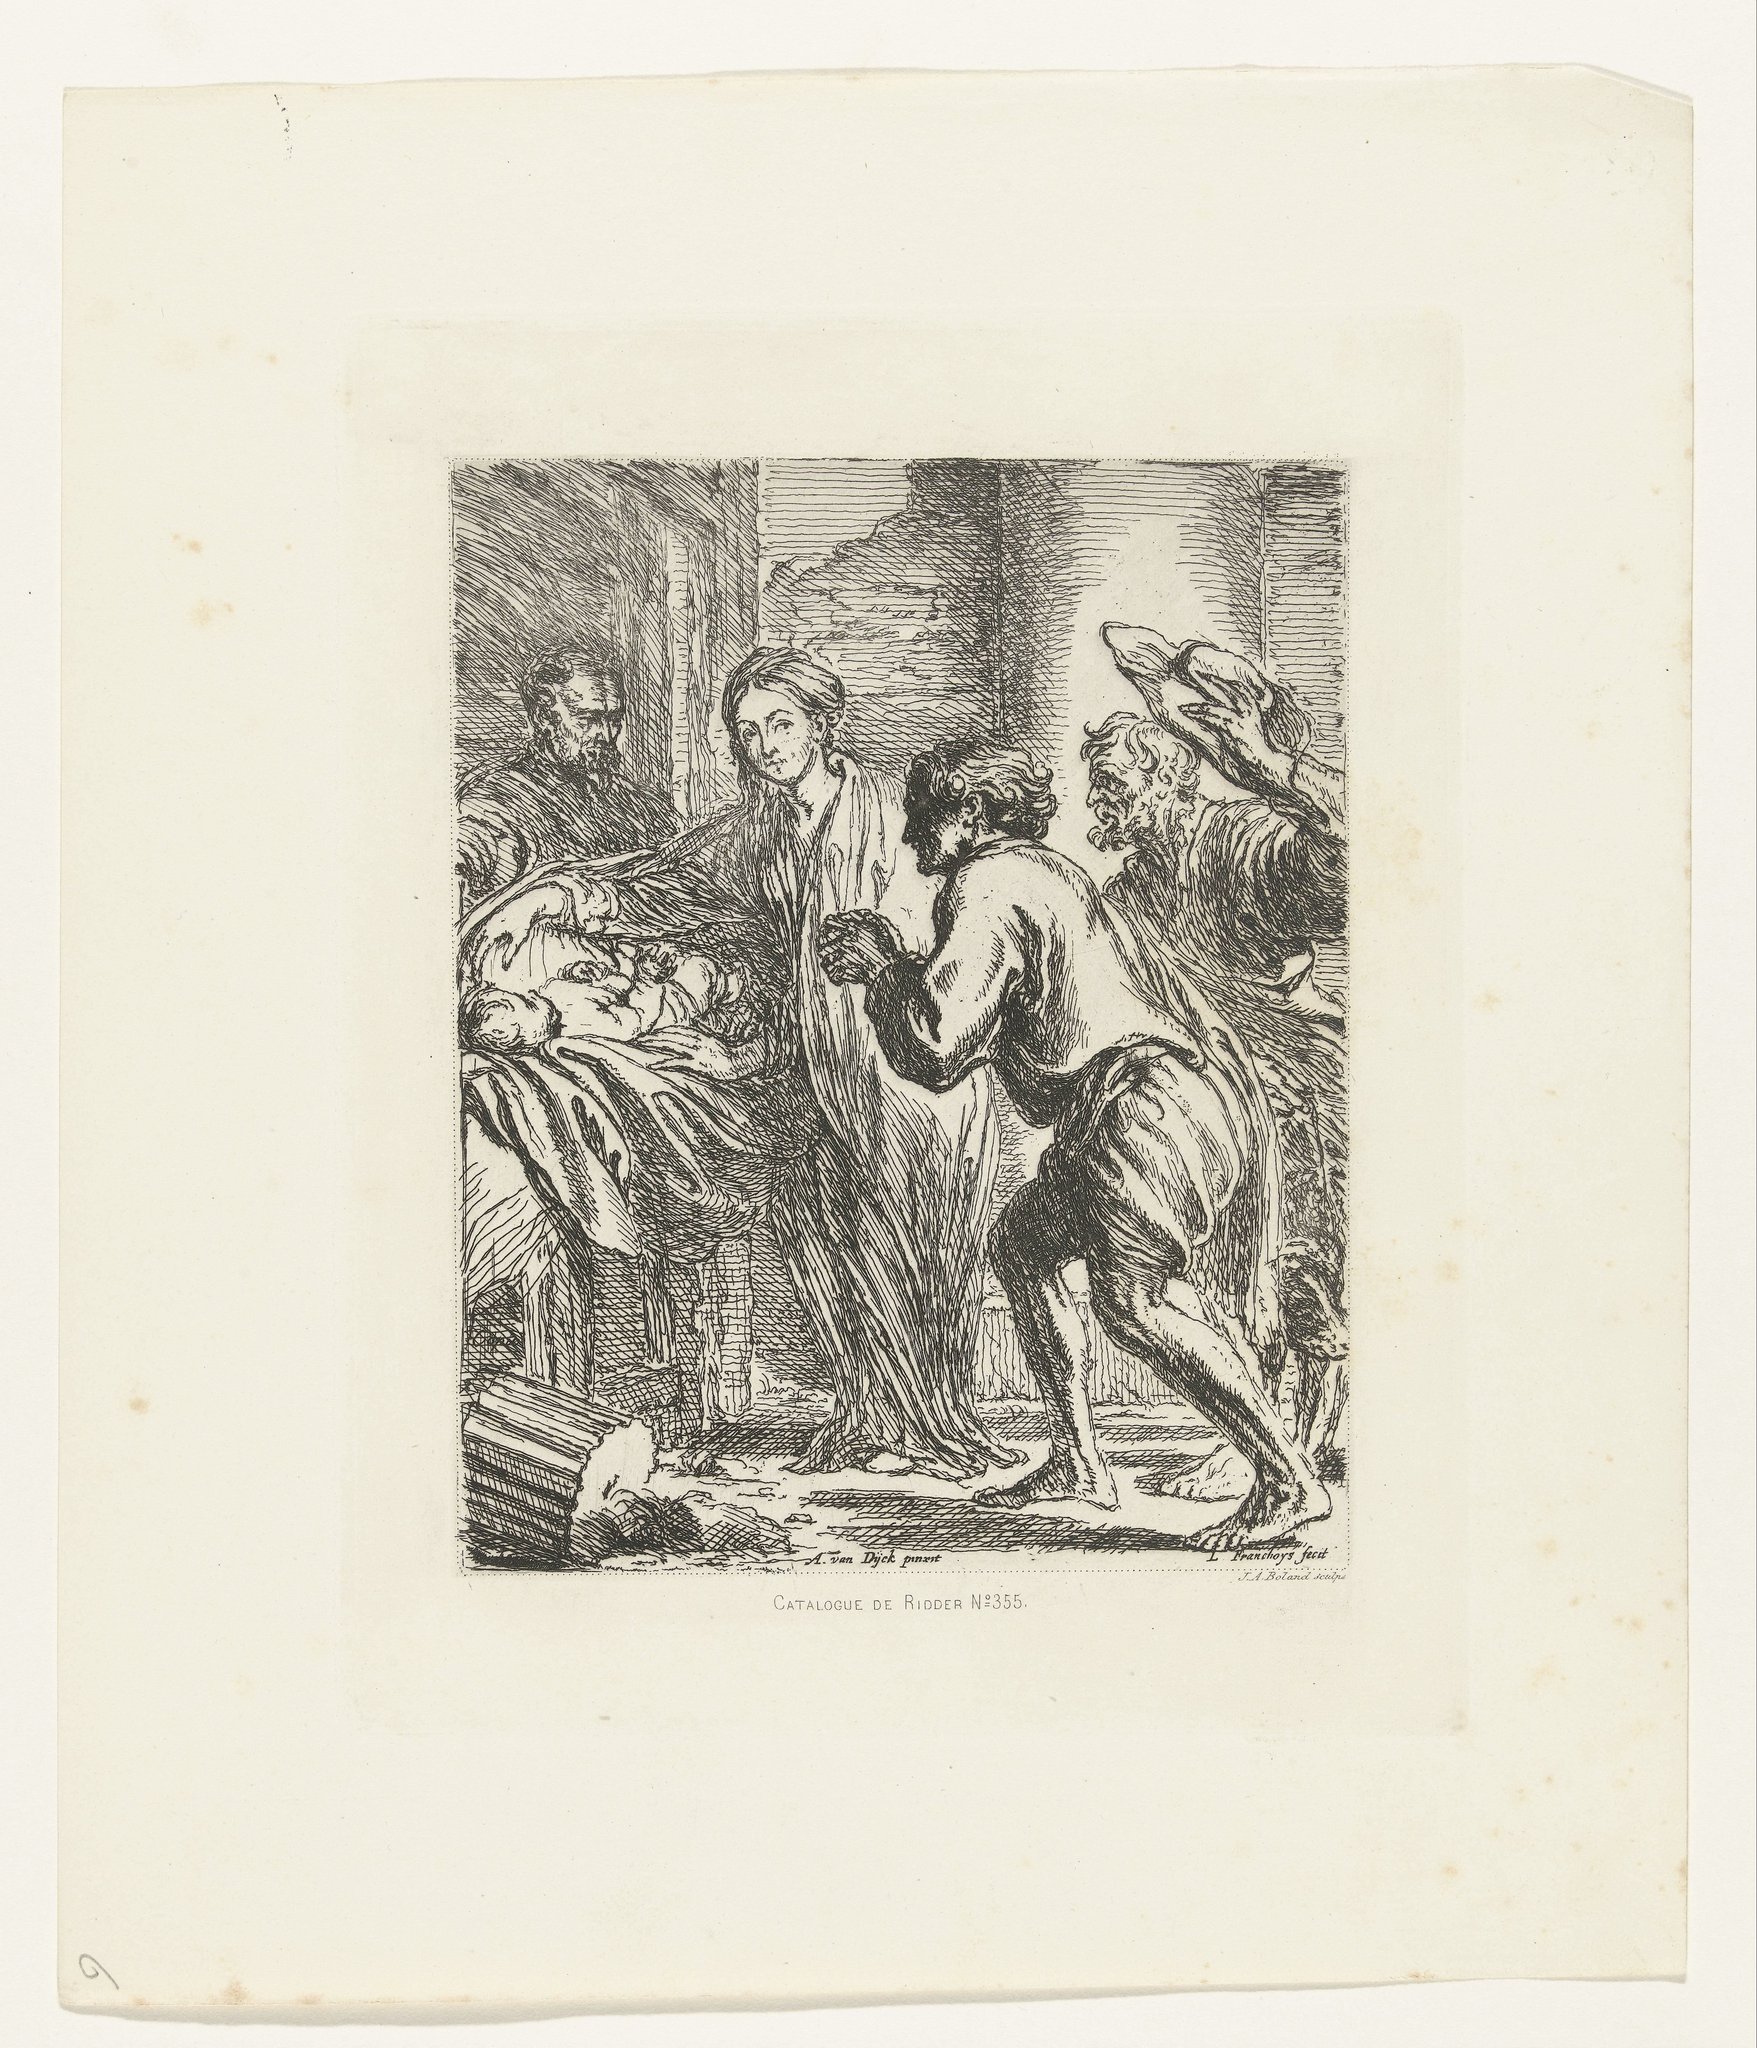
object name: print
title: Aanbidding door de herders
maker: johannes arnoldus boland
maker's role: print maker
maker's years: 1838-1922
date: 1874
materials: paper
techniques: etching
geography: amsterdam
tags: adoration of the christ-child by the shepherds; mary and joseph present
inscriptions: collector's mark: Lugt 2228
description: Illustratie voor de catalogus van de collectie C.C.J. de Ridder (Utrecht), verschenen in 1874.